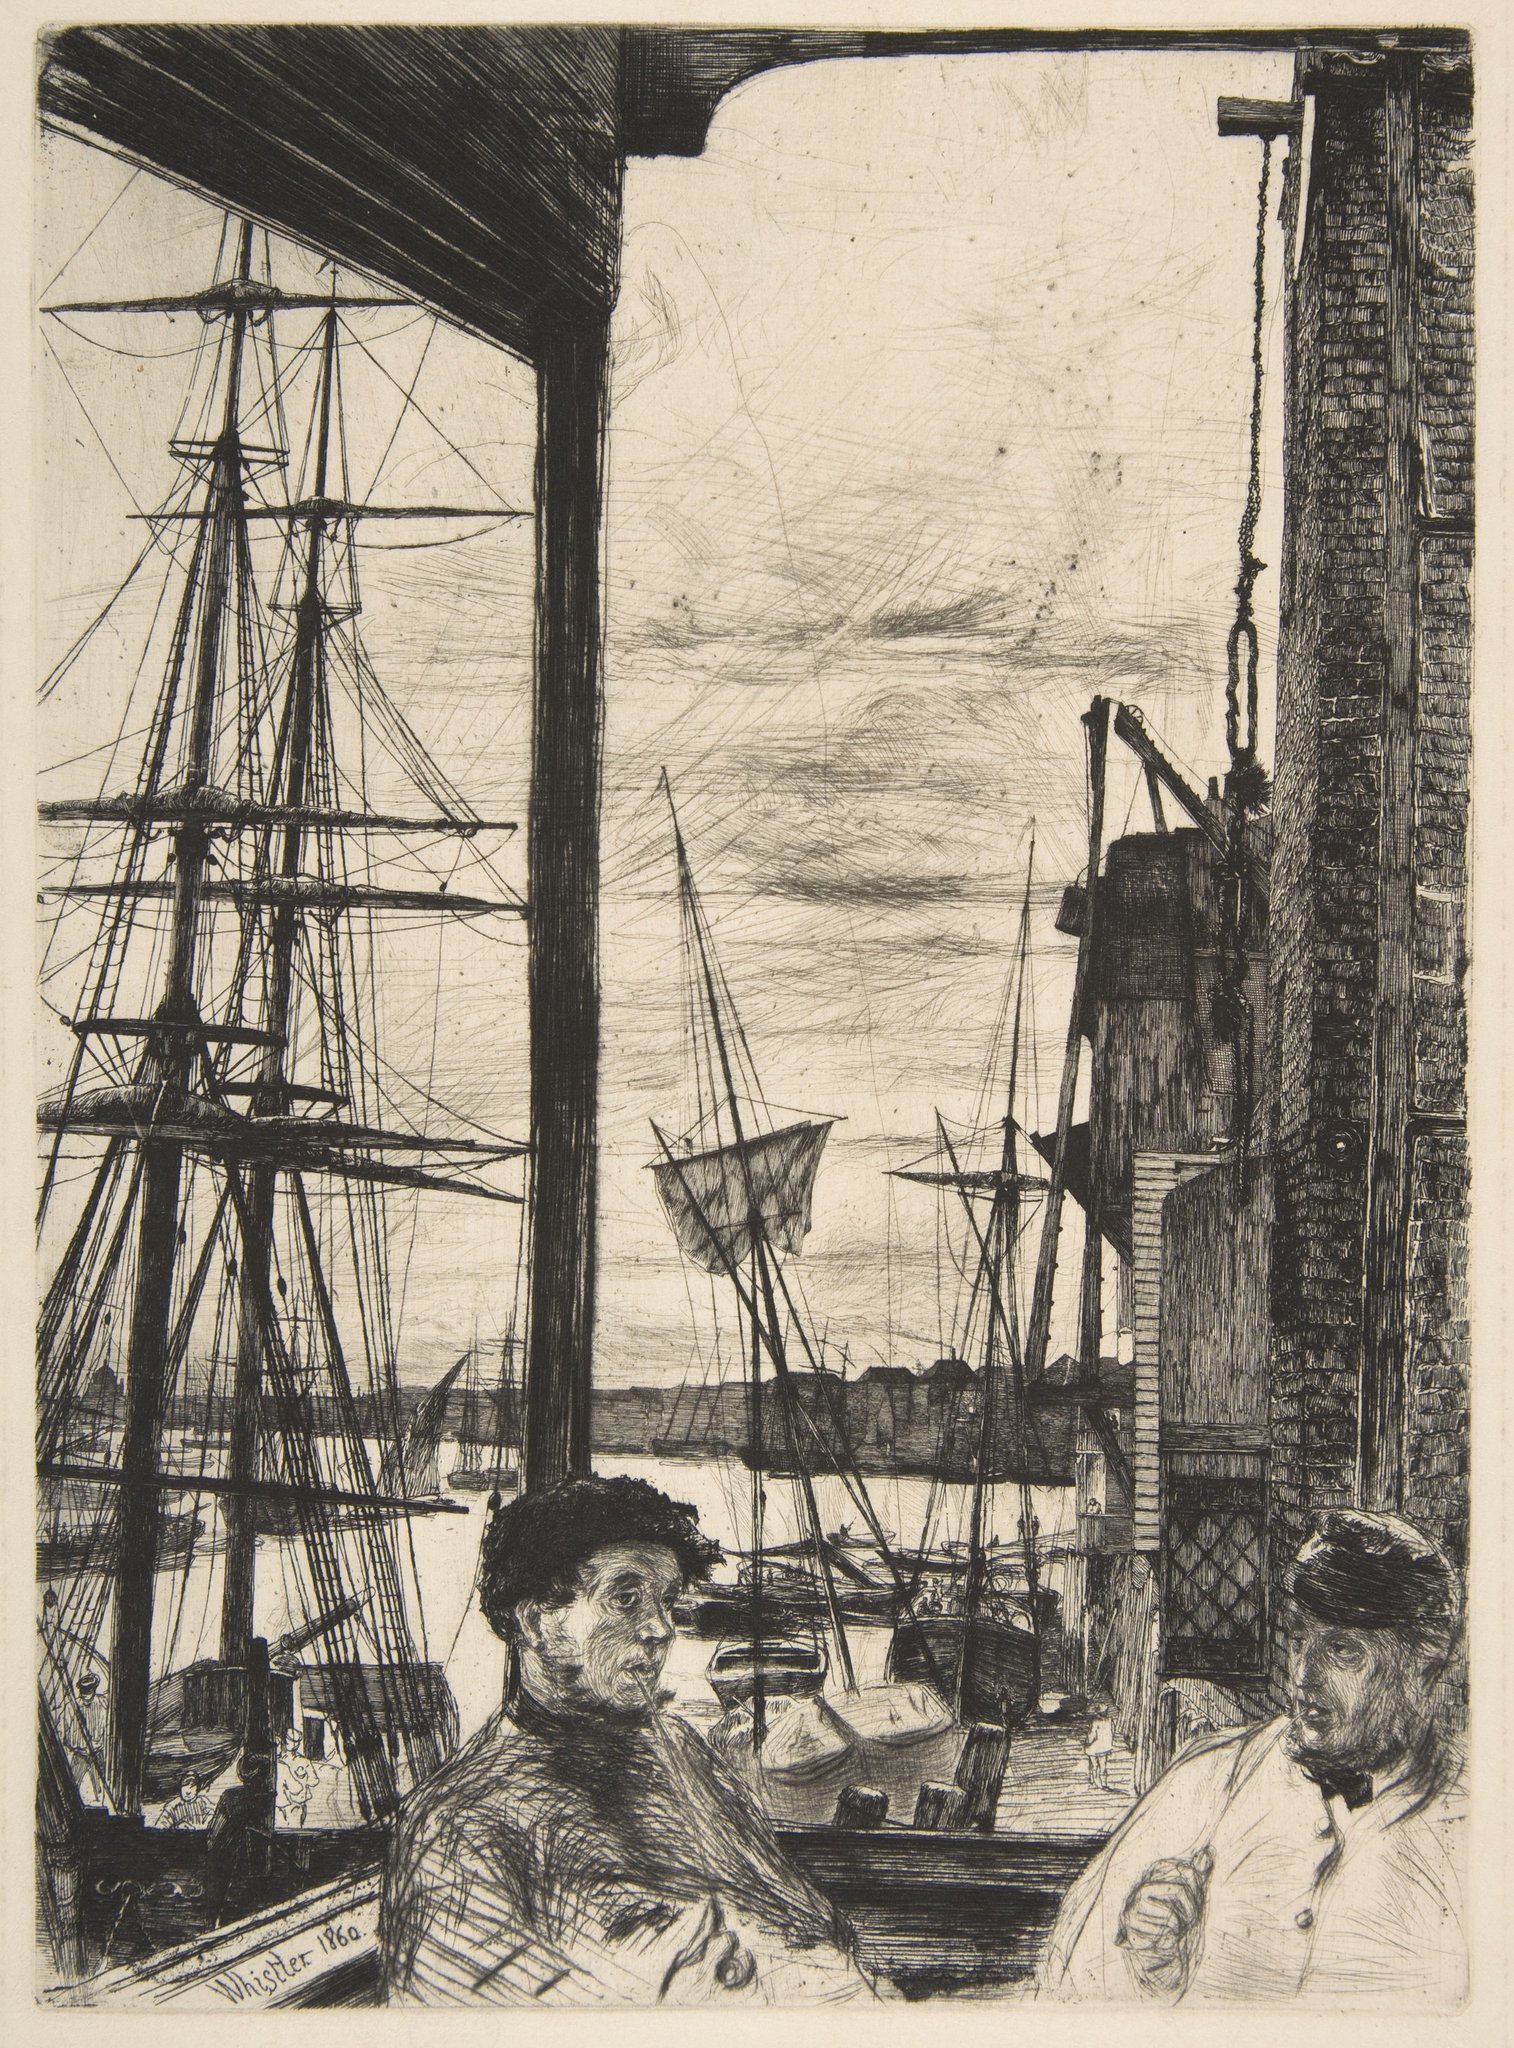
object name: print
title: Rotherhithe (Wapping)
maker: james mcneill whistler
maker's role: artist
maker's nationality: american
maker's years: 1834-1903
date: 1860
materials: ink, ivory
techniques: drypoint, etching, printing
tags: men,ships